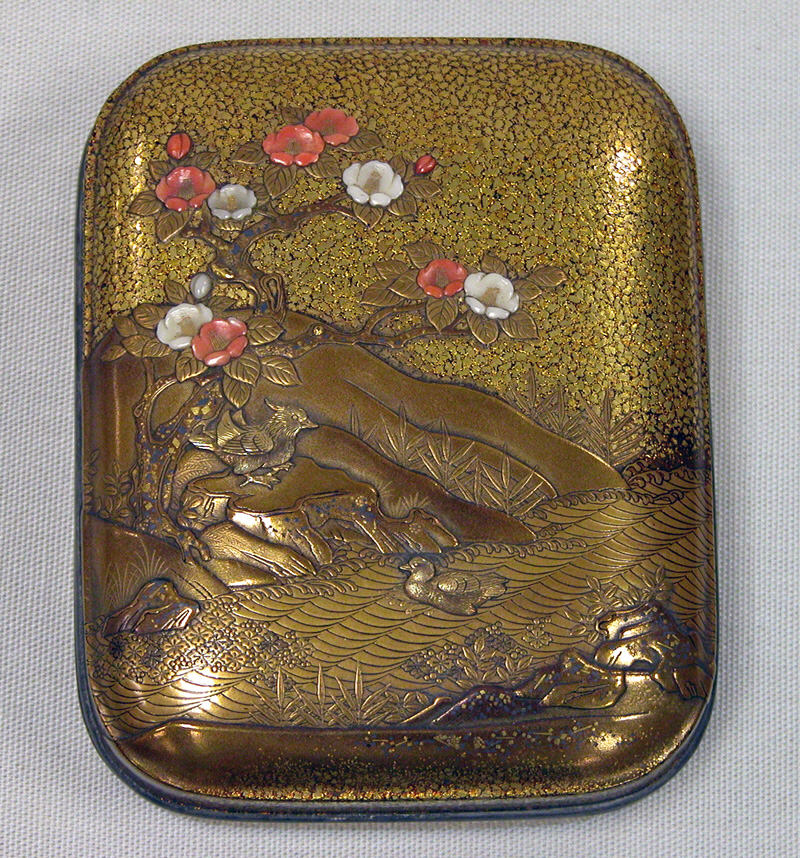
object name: incense container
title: Incense Container (Kōgō) with Camellia and Mandarin Ducks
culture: japanese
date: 1701-1800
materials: coral, gold, gold foil, ivory, silver, wood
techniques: cutting, hiramakie, inlay, lacquer, maki-e